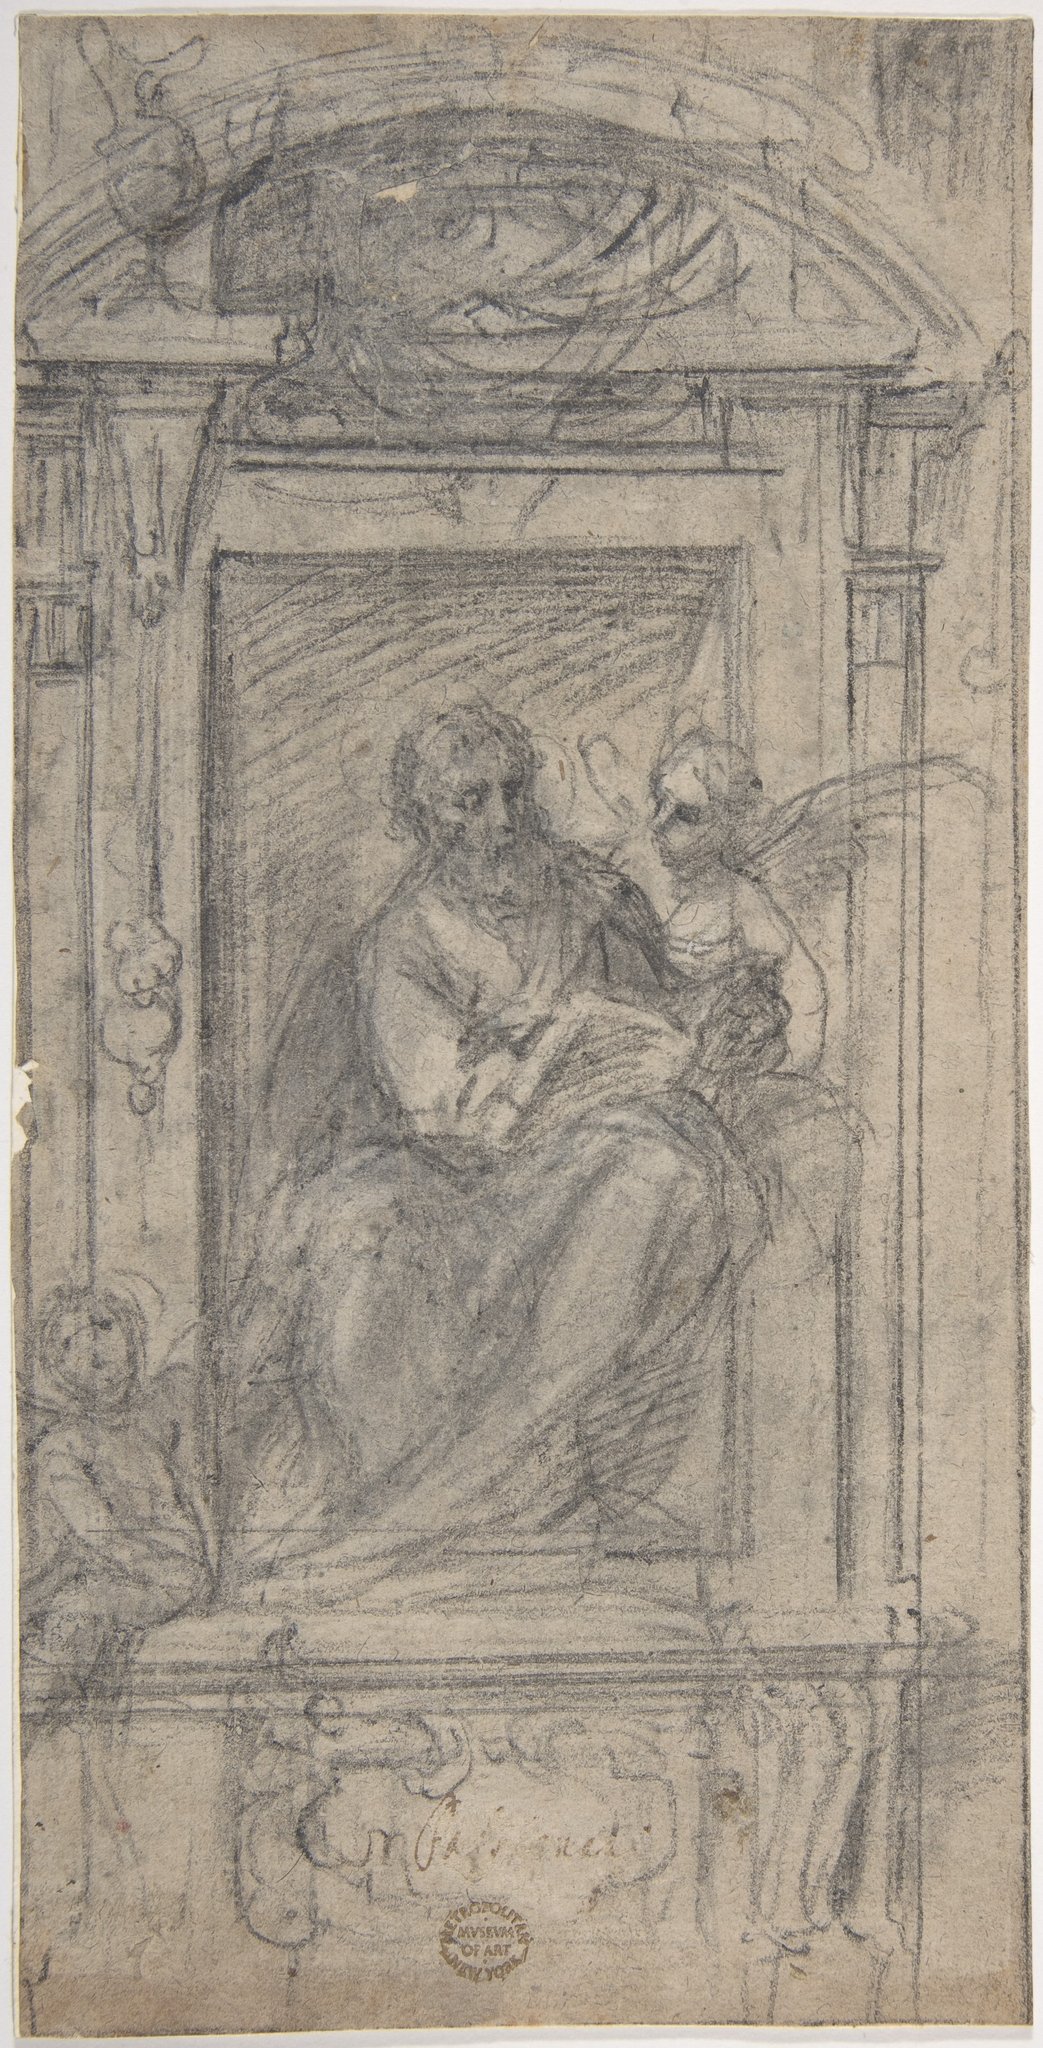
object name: drawing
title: Saint Matthew Seated in a Niche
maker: fabrizio boschi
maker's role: artist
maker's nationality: italian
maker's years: 1572-1642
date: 1572-1642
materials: chalk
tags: angels,saint matthew